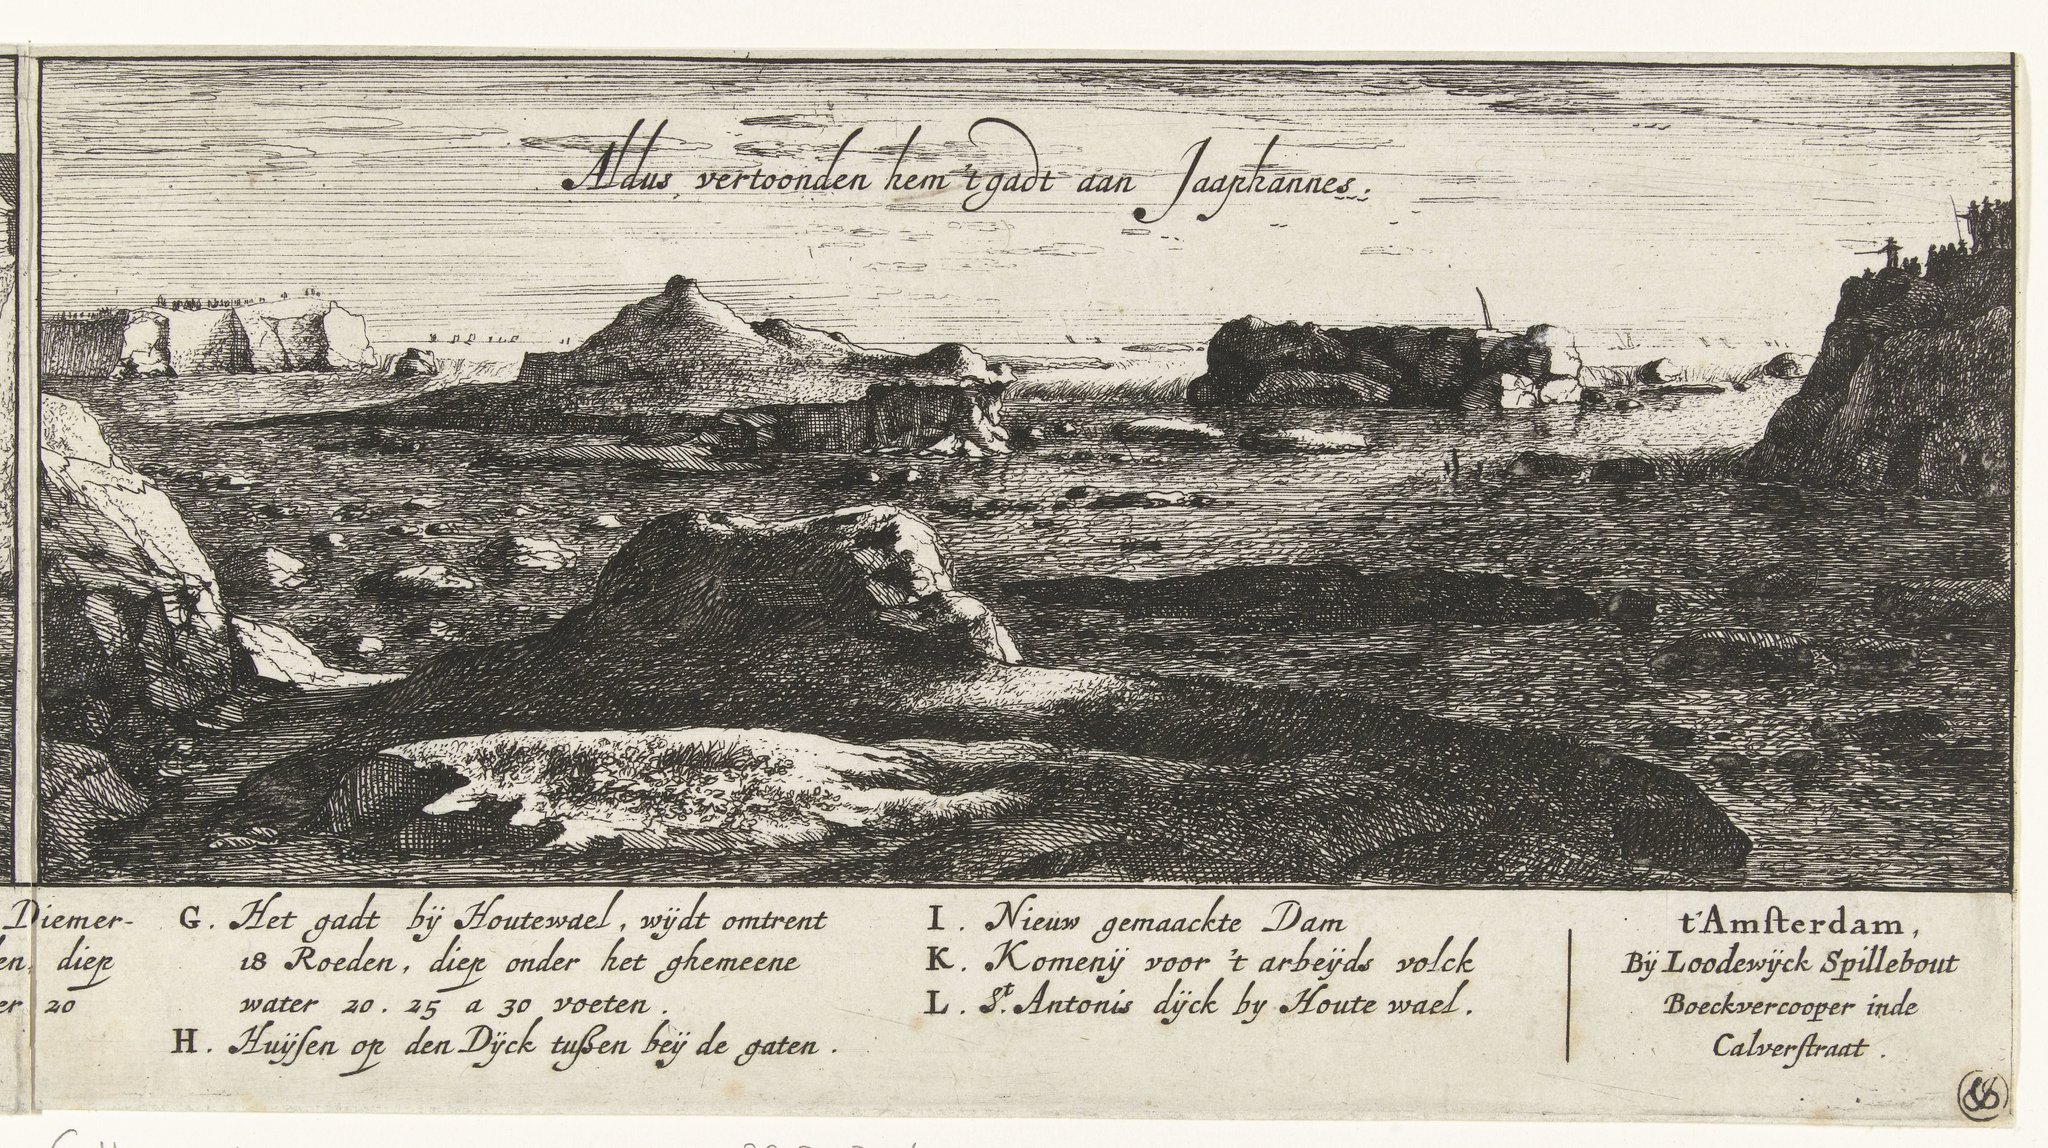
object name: print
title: Aldus vertoonden hem 't gadt aan Jaaphannes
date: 1651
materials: paper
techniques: etching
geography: northern netherlands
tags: dike-break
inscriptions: collector's mark: Lugt 573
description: De doorgebroken Sint-Antoniesdijk of Diemerzeedijk bij de herberg Jaap Hannes, 5 maart 1651. In het onderschrift de tweede helft van de legenda G-L. Onderdeel van een grote plaat bestaande uit vier afbeeldingen en een tekstblad met een vers.